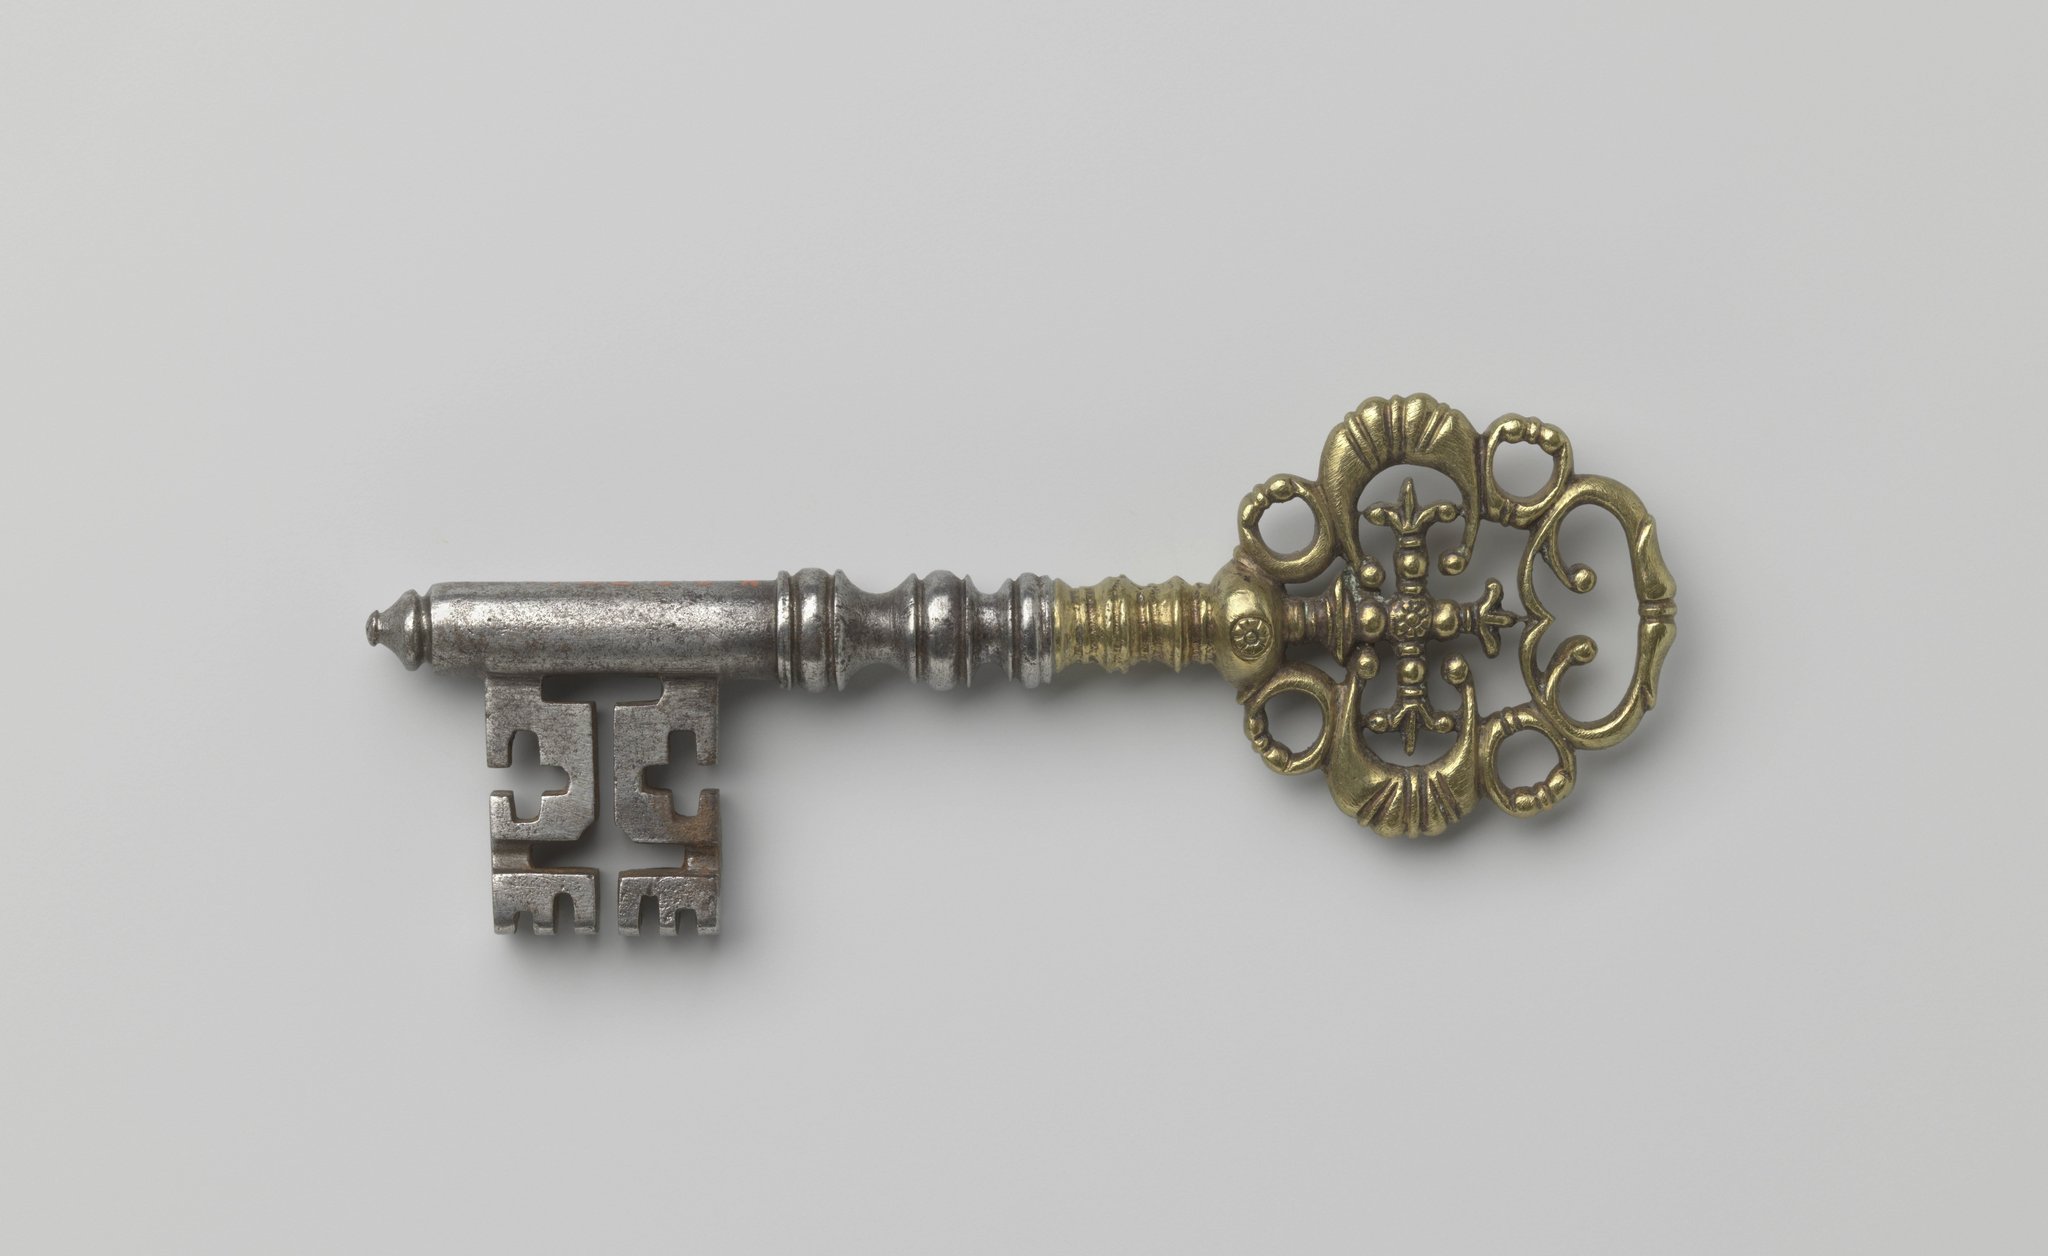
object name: key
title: Sleutel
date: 1700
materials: bronze, iron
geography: england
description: Sleutel waarvan de greep bestaat uit ingesneden halve maantjes die een kruisvormige bloem met bladmotief insluiten. De zwaar geprofileerde schacht eindigt in een geprofileerd knopje. Bovenhelft in brons, onderhelft ijzer.